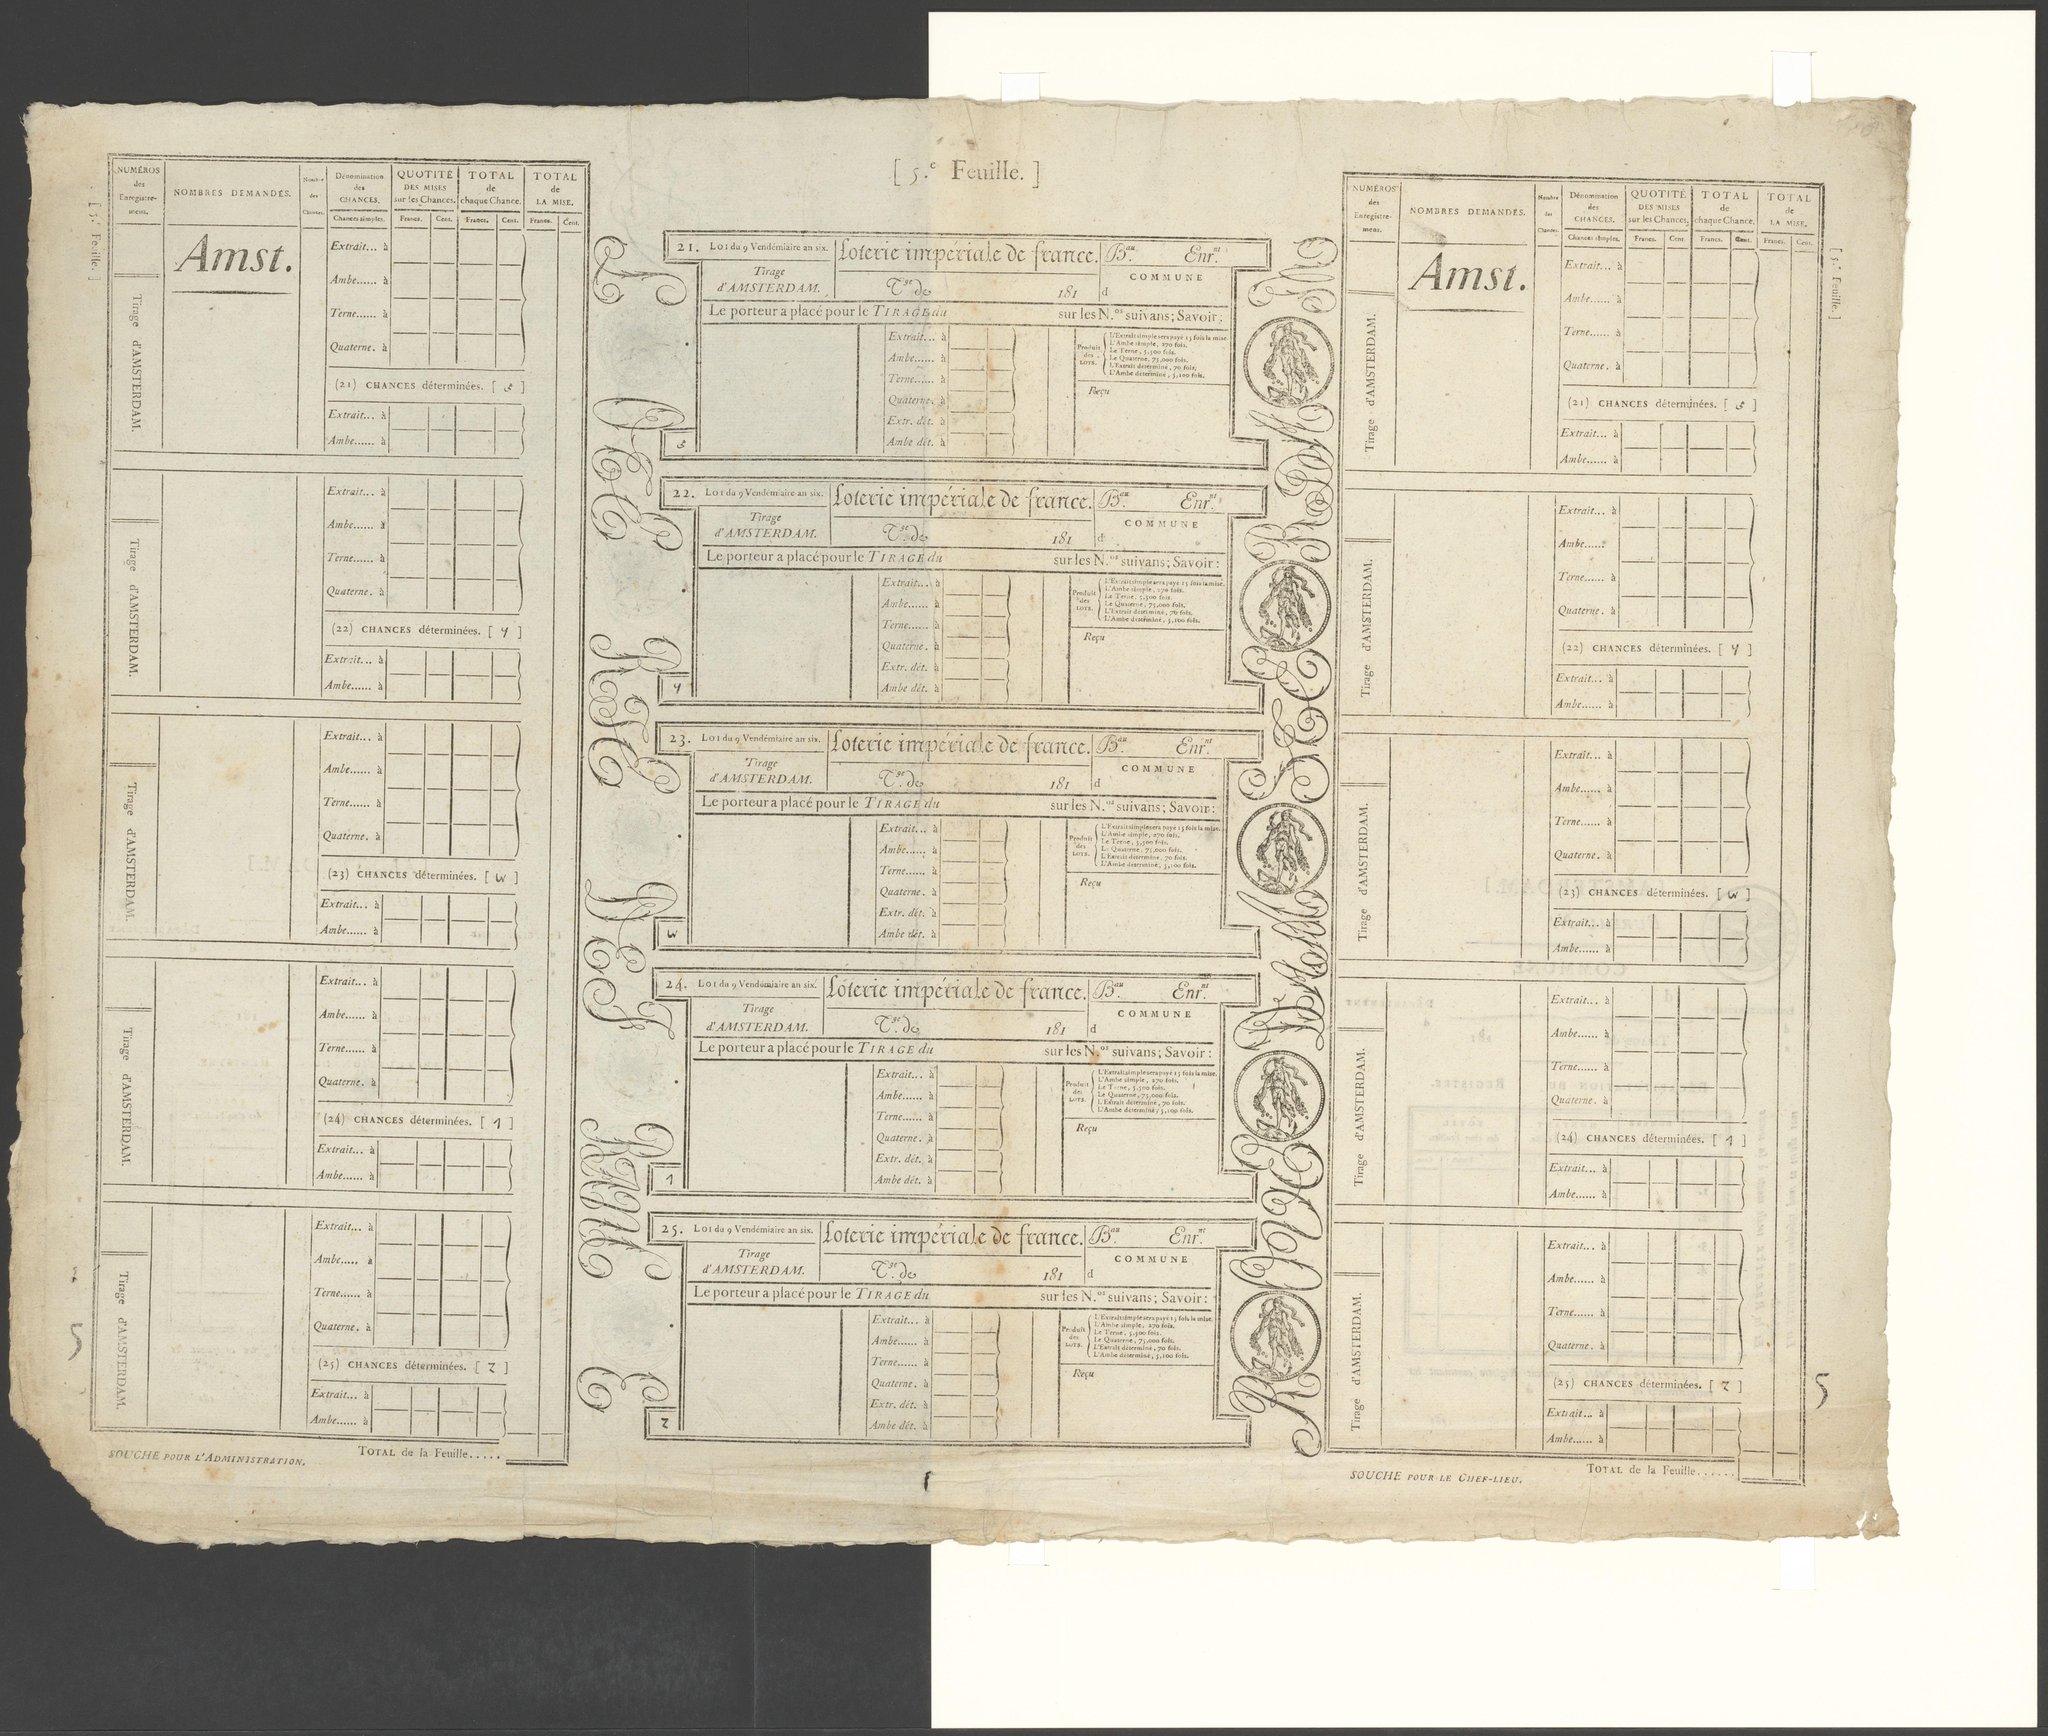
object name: text sheet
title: Onversneden blad met loterijbriefjes van de 'Loterie impériale de france' / 5.re Feuille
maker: Anonymous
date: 1810-1815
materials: paper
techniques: letterpress printing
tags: raffle, lottery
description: Onversneden blad met loterijbriefjes nrs. 21-25 voor de 'Tirage d'Amsterdam' van de van de 'Loterie impériale de france'. Blad genummerd bovenaan '3e Feuille'. Zoals vastgelegd bij de wet in Vendémiaire (jaar 1797-1798), met voorgedrukte trekkingsdatum 181... Op de buitenzijde ook bedrukt met een in te vullen 'Récapitilation du Registre'. Onderwerpsrubrieken binnen de Atlas Zeden en Gewoonten: Spel en Vermaak; Loterij.